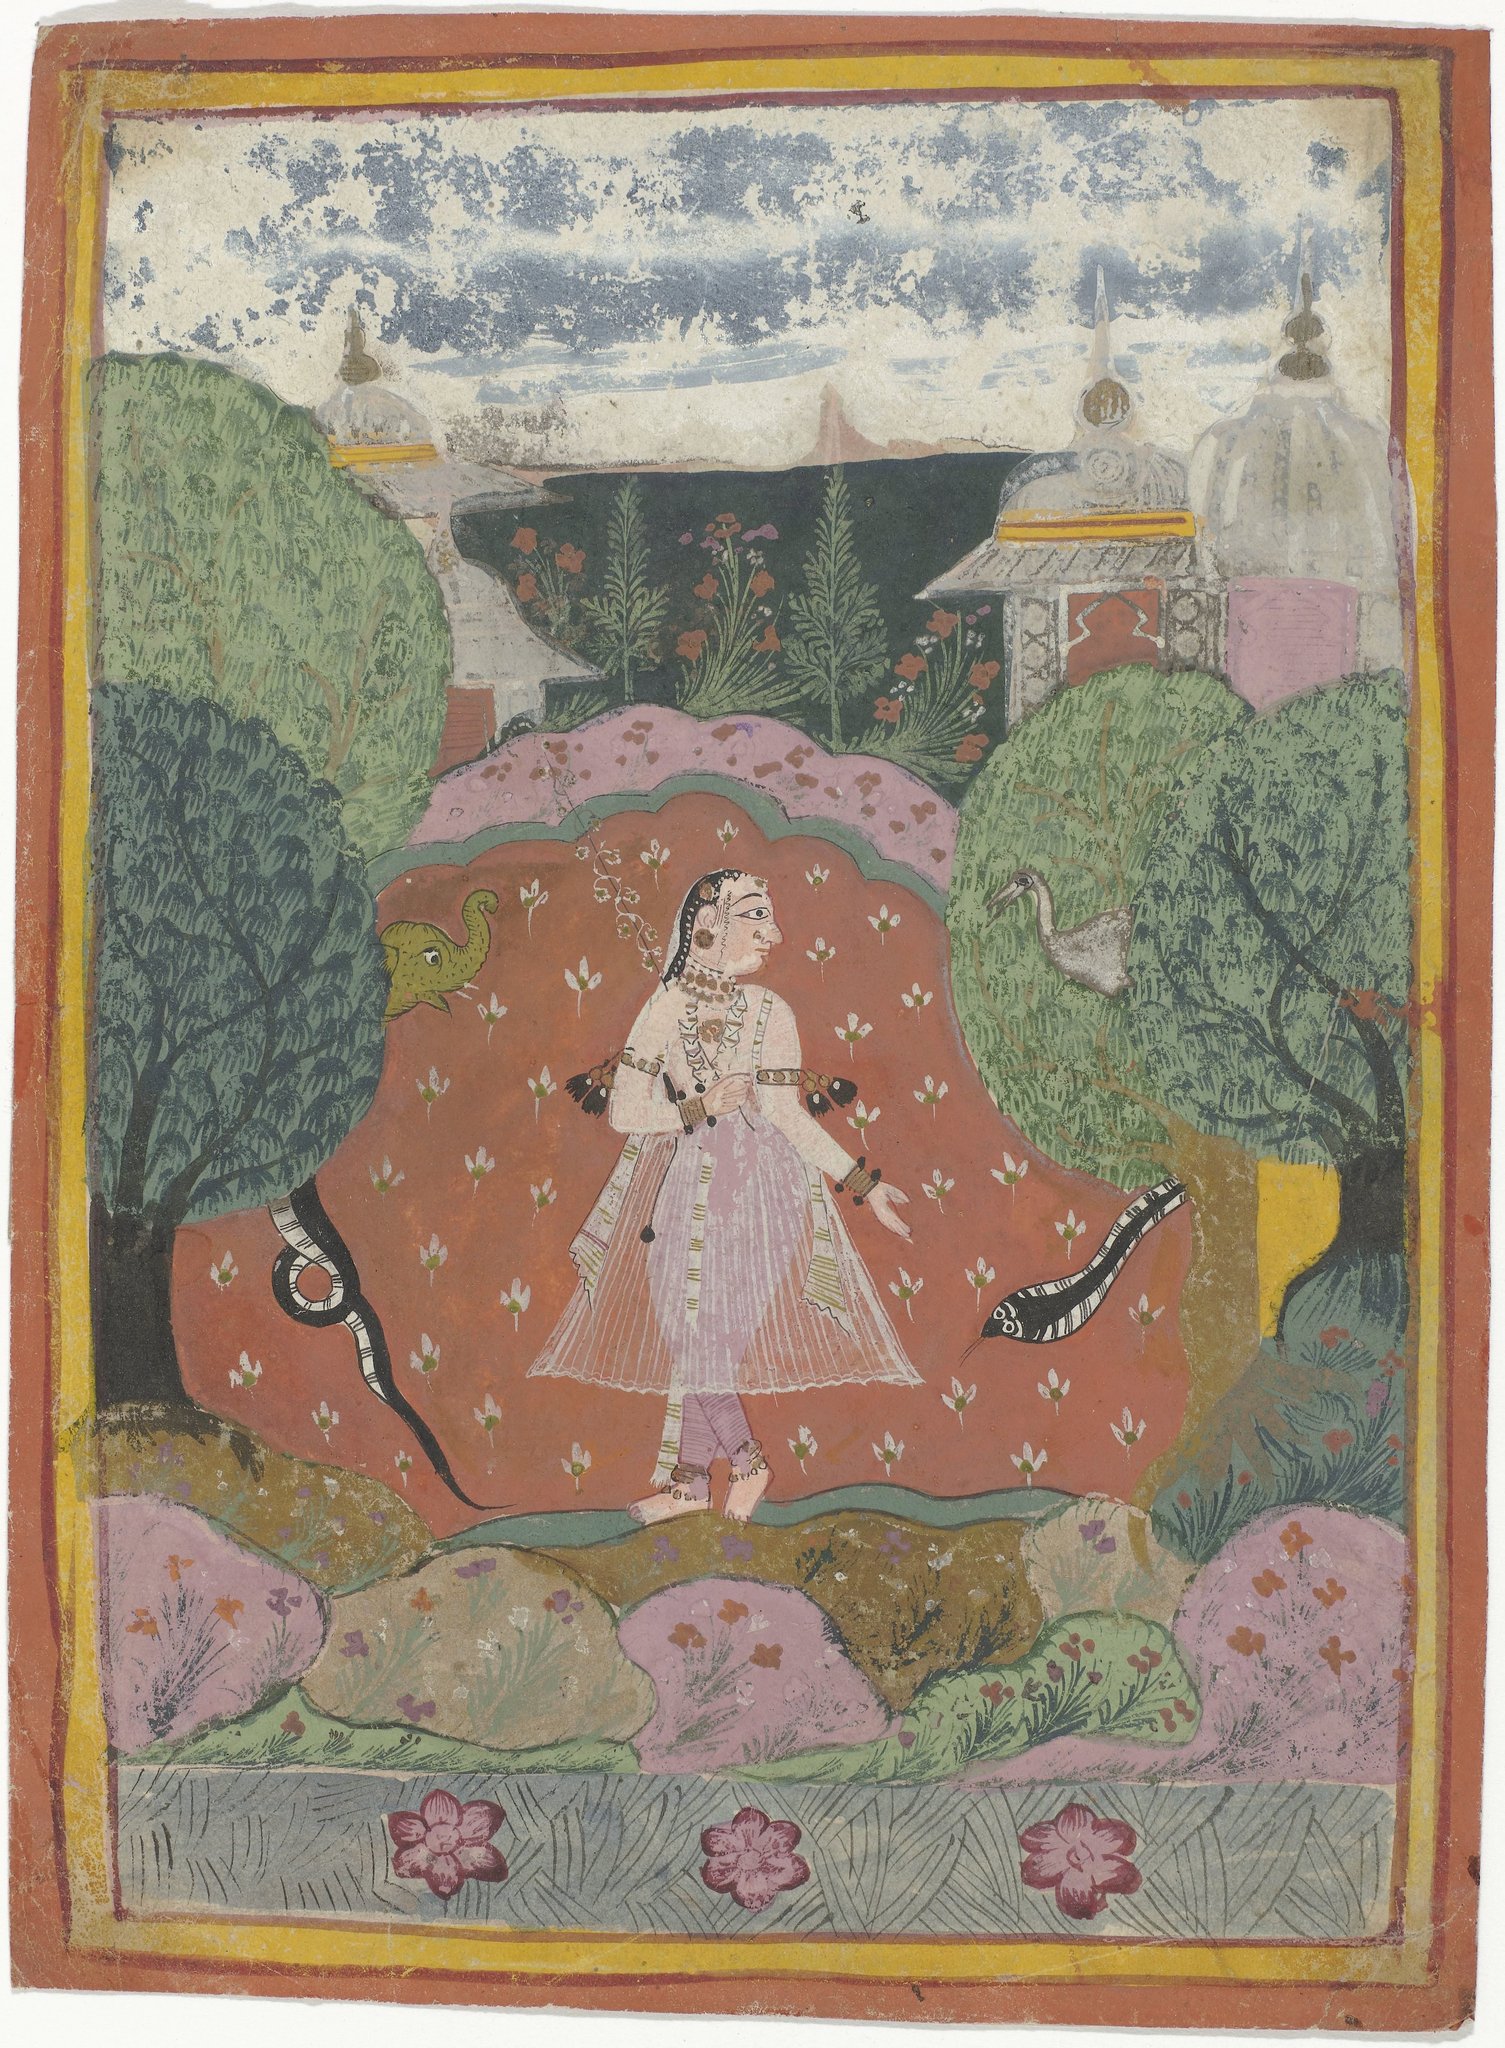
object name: indian miniature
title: Asavari ragini(?)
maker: Anonymous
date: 1710-1730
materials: paper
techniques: brush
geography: central india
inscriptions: inscription: ‘.’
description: Een vrouw in een landschap, om haar heen slangen en vogels. Om de voorstelling twee smalle randen in geel en rood.